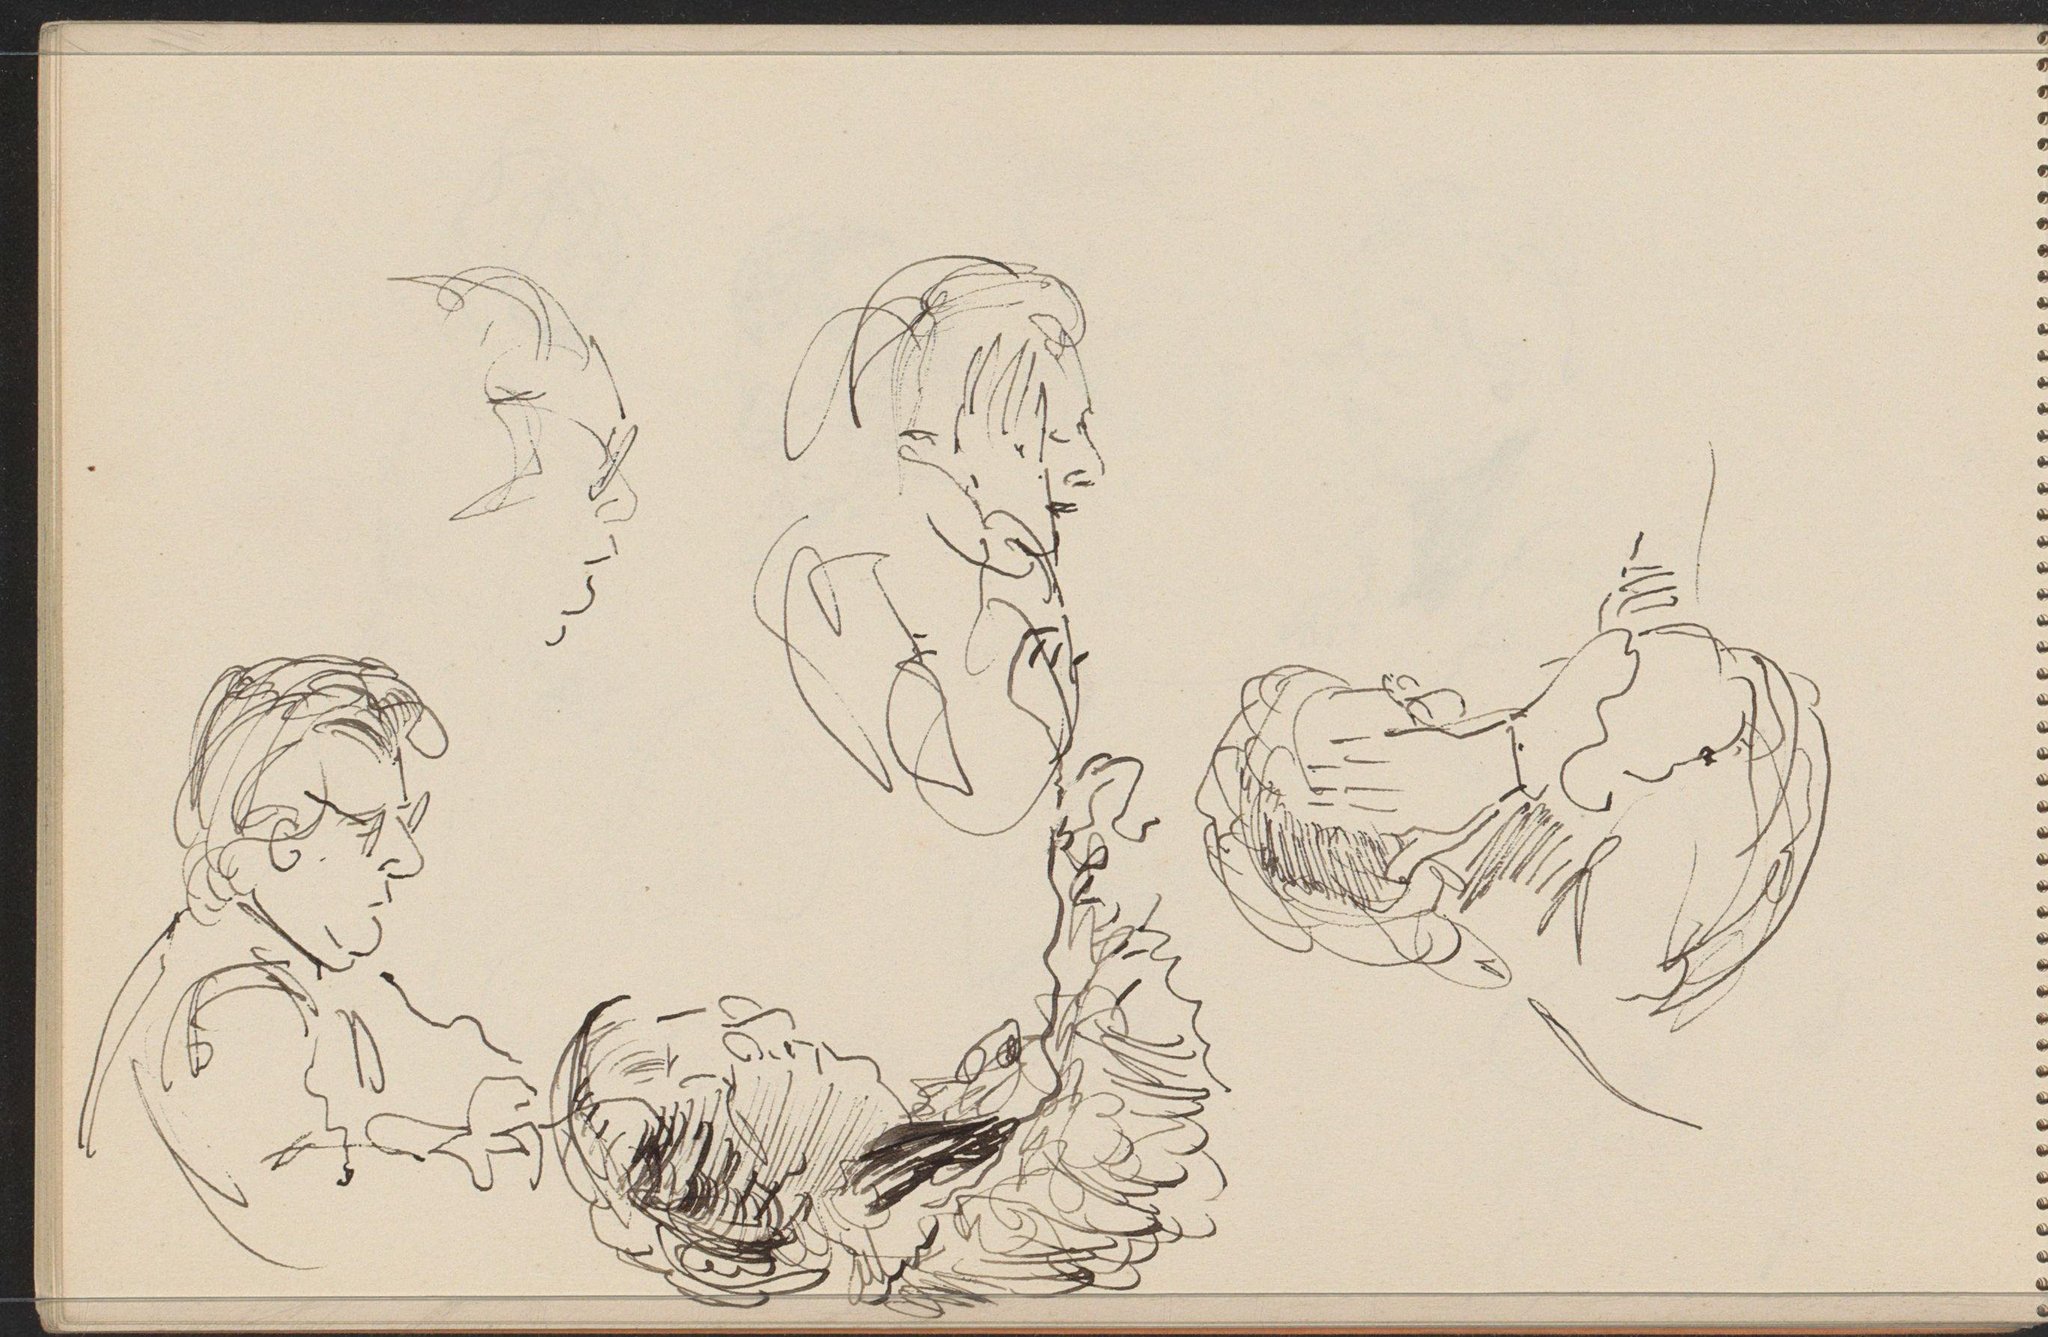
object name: sketchbook leaf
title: Portretten van Joanna Lion Cachet-Cordes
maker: carel adolph lion cachet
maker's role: draughtsman, print maker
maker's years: 1864-1945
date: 1935-1940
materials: ink, paper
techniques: pen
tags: adult woman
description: Joanna Lion Cachet-Cordes is getekend met haar armen in verschillende houdingen. Blad 17 verso uit een schetsboek met 25 bladen.